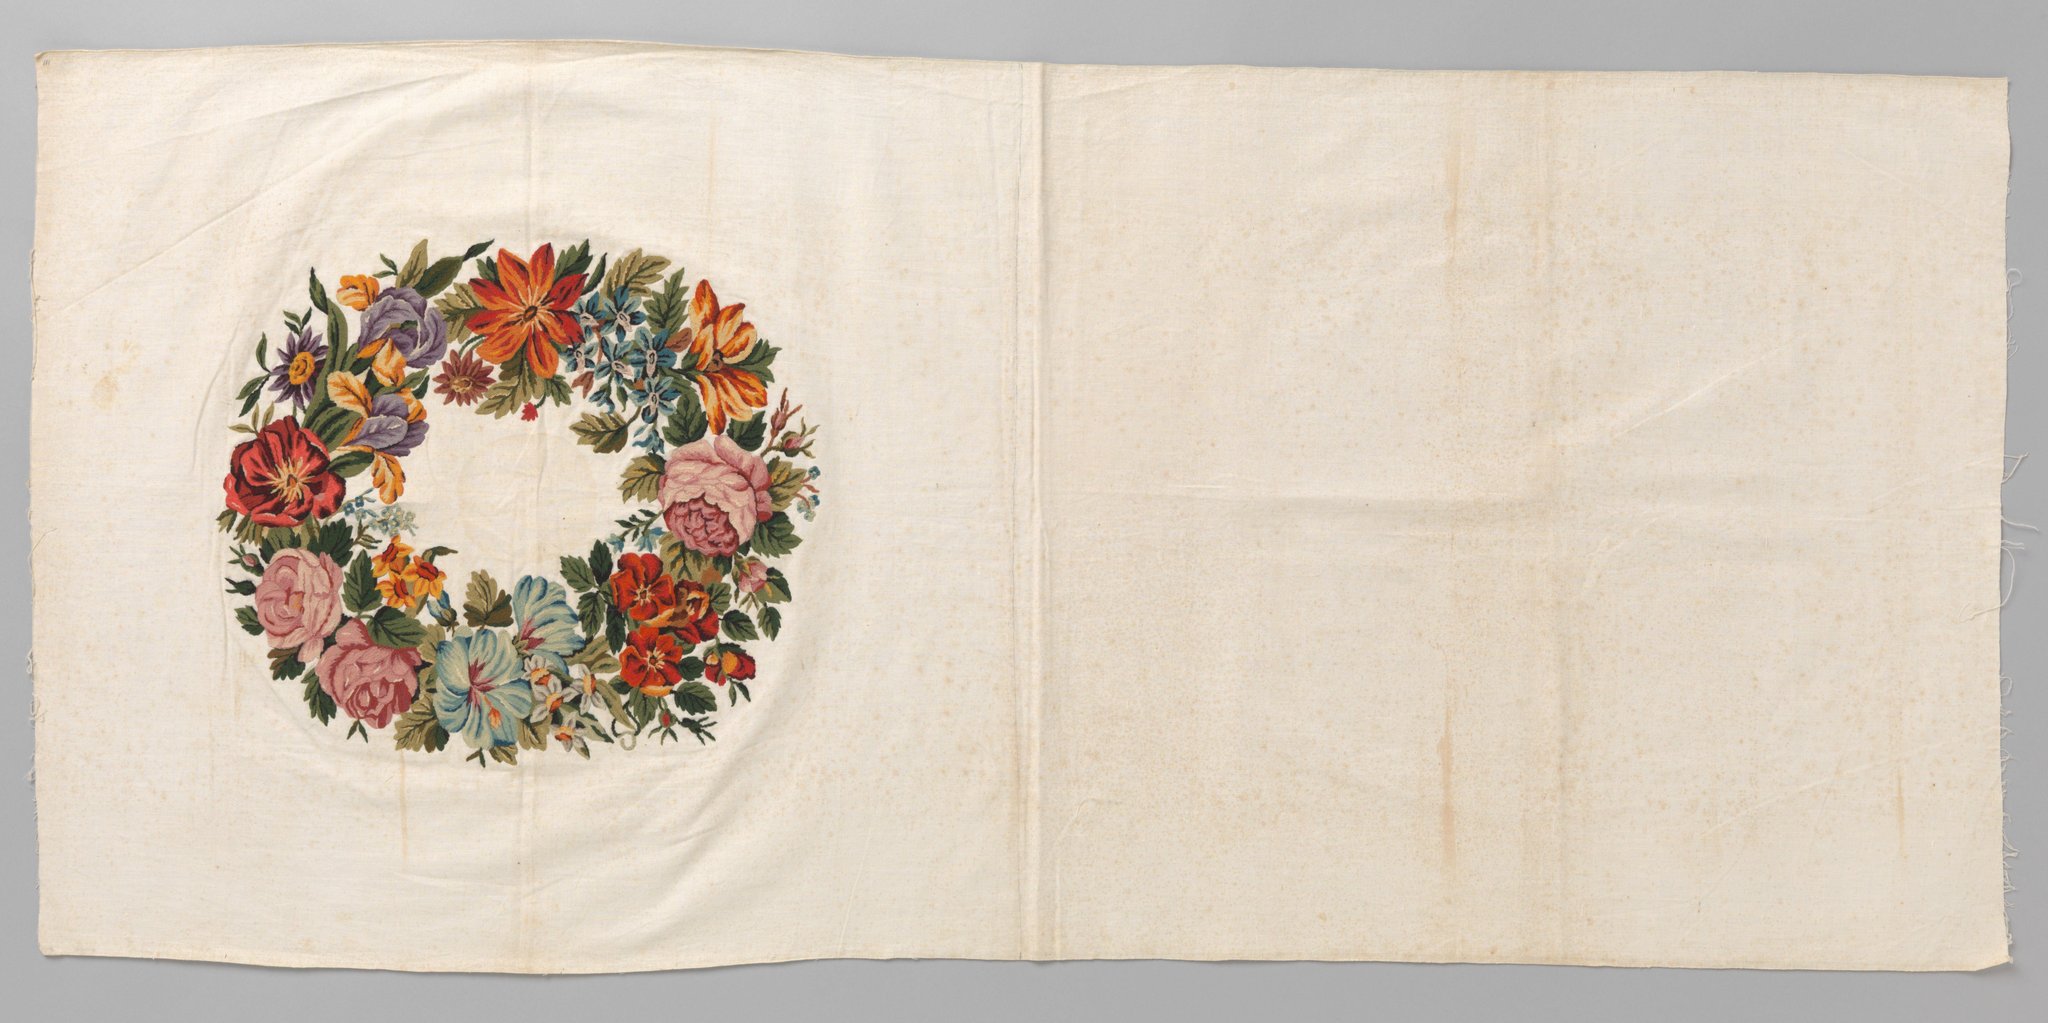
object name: bekledingsstof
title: Metrage bekledingsstof met borduurwerk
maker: Anonymous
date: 1850-1949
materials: cotton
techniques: weave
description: Metrage bekledingsstof, geborduurd met kleurige bloemenkransen in kettingsteek.